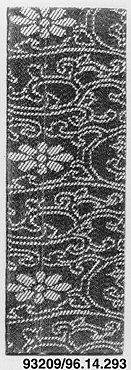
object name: piece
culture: japanese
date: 1701-1900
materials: silk